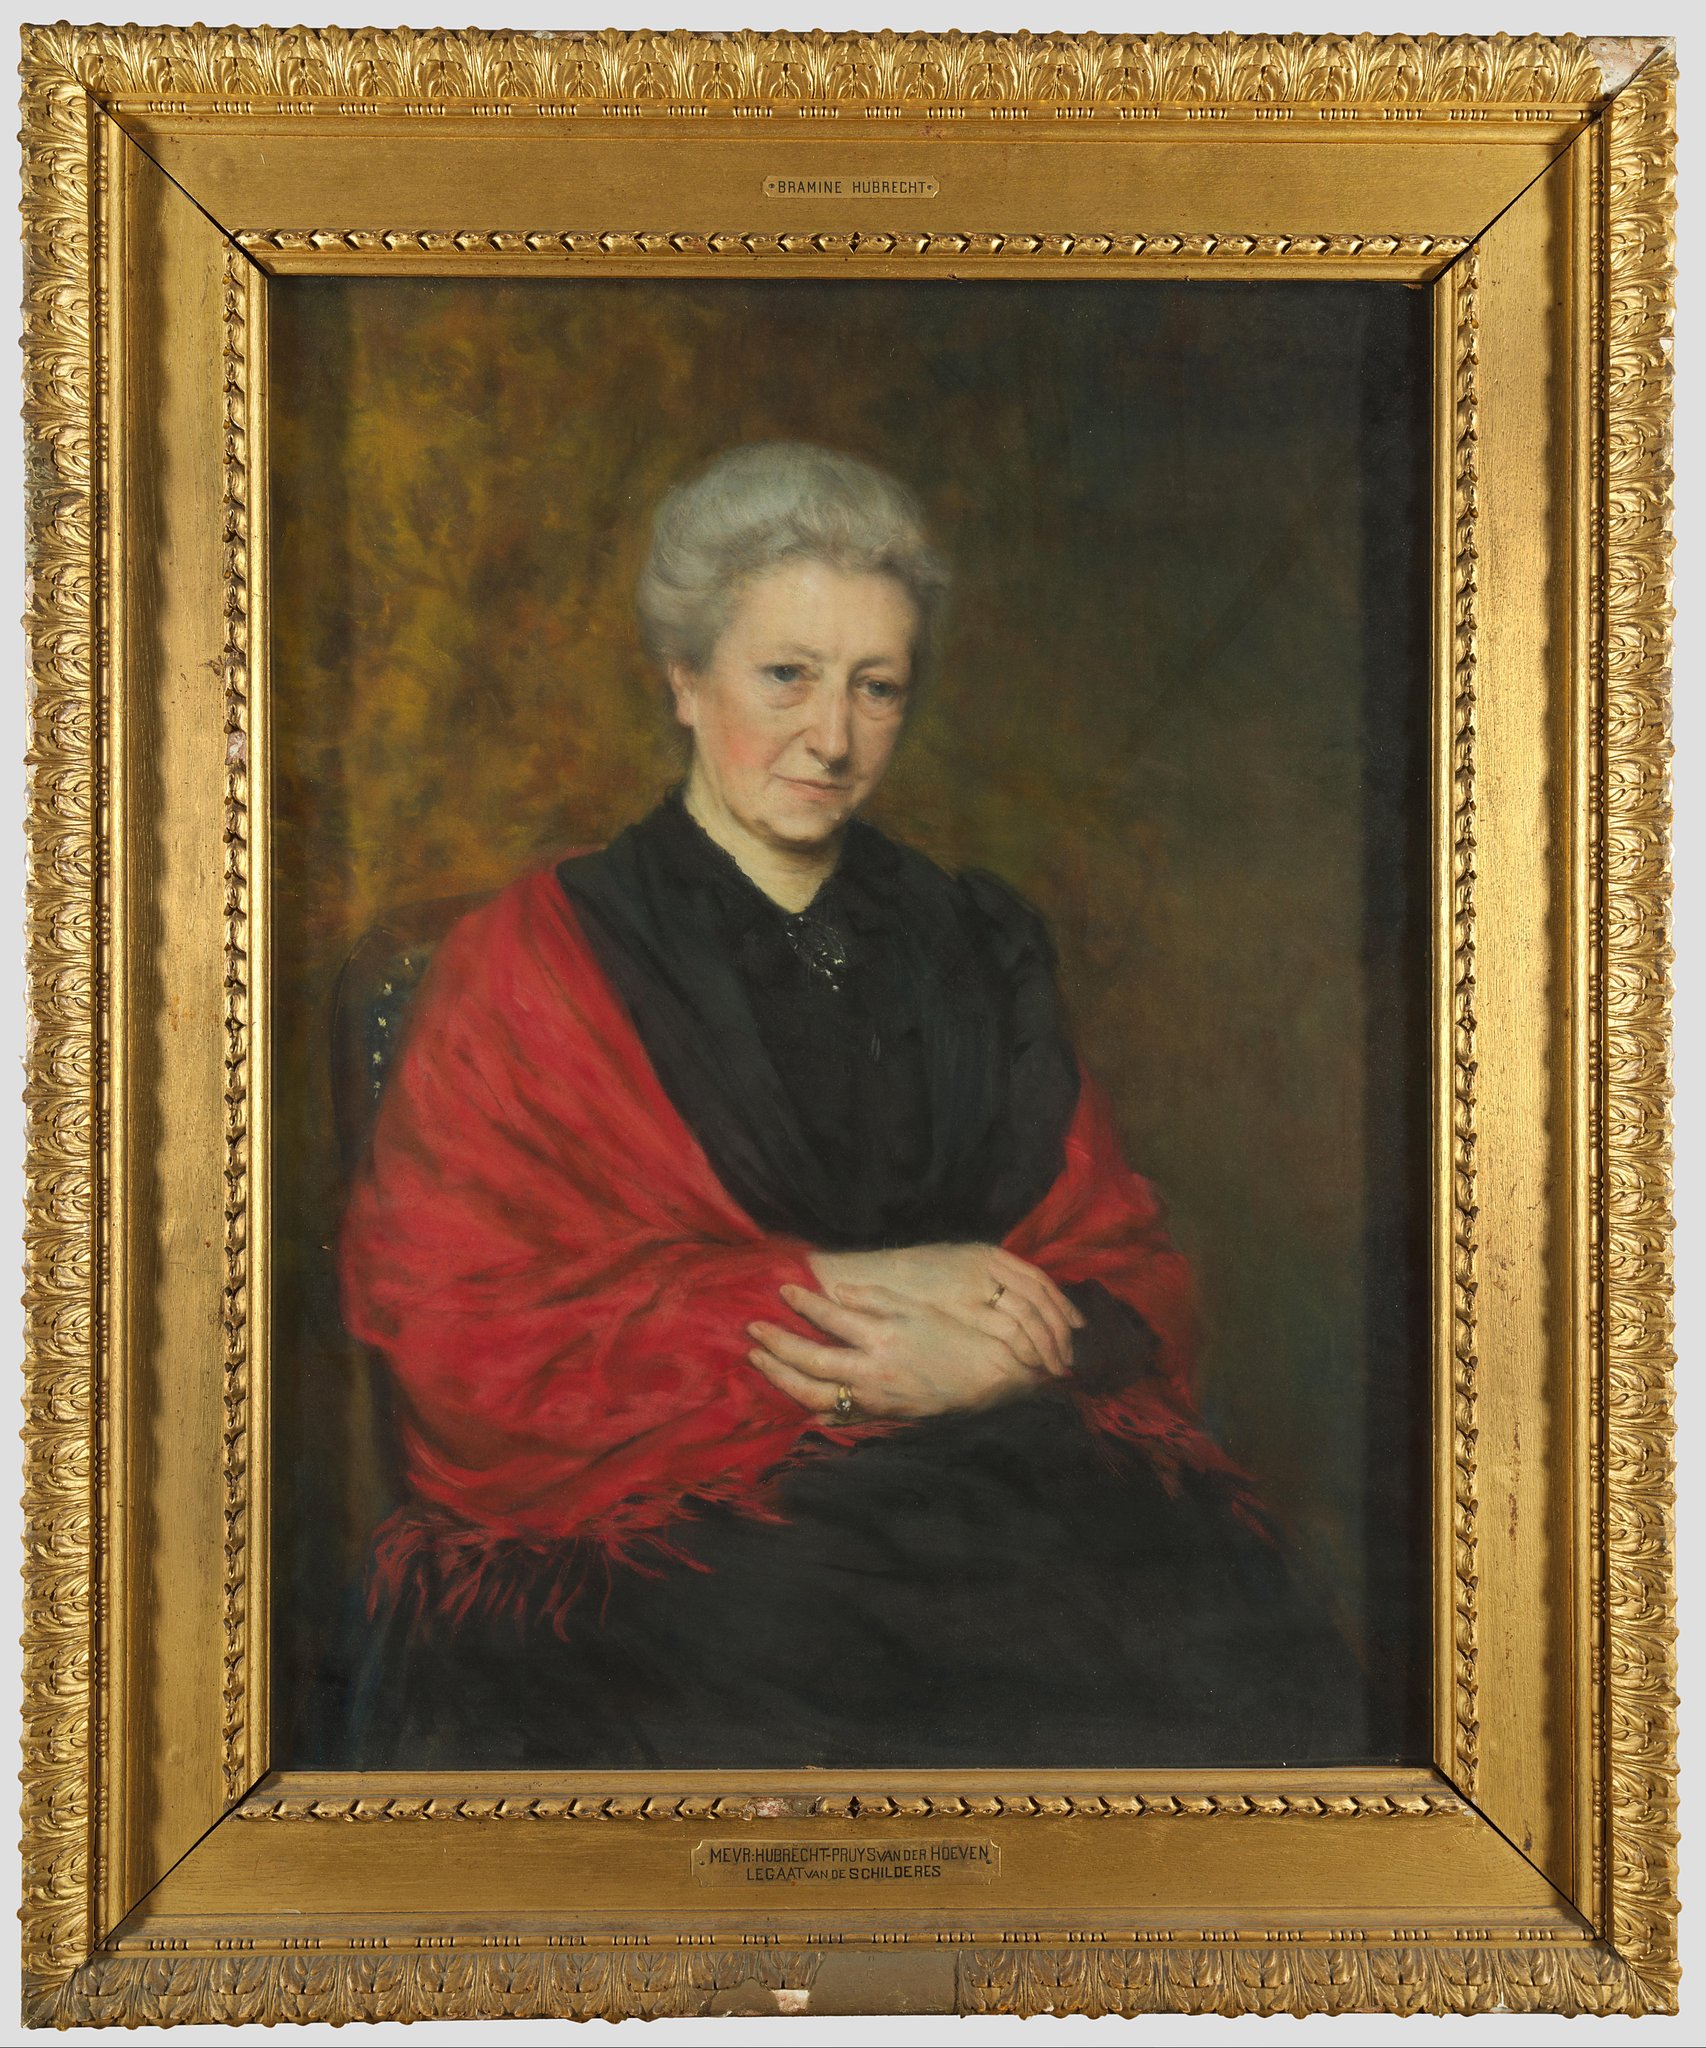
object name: drawing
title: Maria Pruys van der Hoeven (1824-1901). Echtgenote van Paul François Hubrecht (1829-1902) en moeder van de kunstenares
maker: a.a.l. de grammont-hubrecht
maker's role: draughtsman, painter, print maker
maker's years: 1855-1913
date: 1865-1901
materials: paper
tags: historical persons - bb - woman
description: Portret van Maria Pruys van der Hoeven (1824-1901). Echtgenote van Paul François Hubrecht (1829-1902) en moeder van de kunstenares. Kniestuk naar rechts, zittend in een stoel met de handen over elkaar in de schoot. Onderdeel van de collectie pastels.